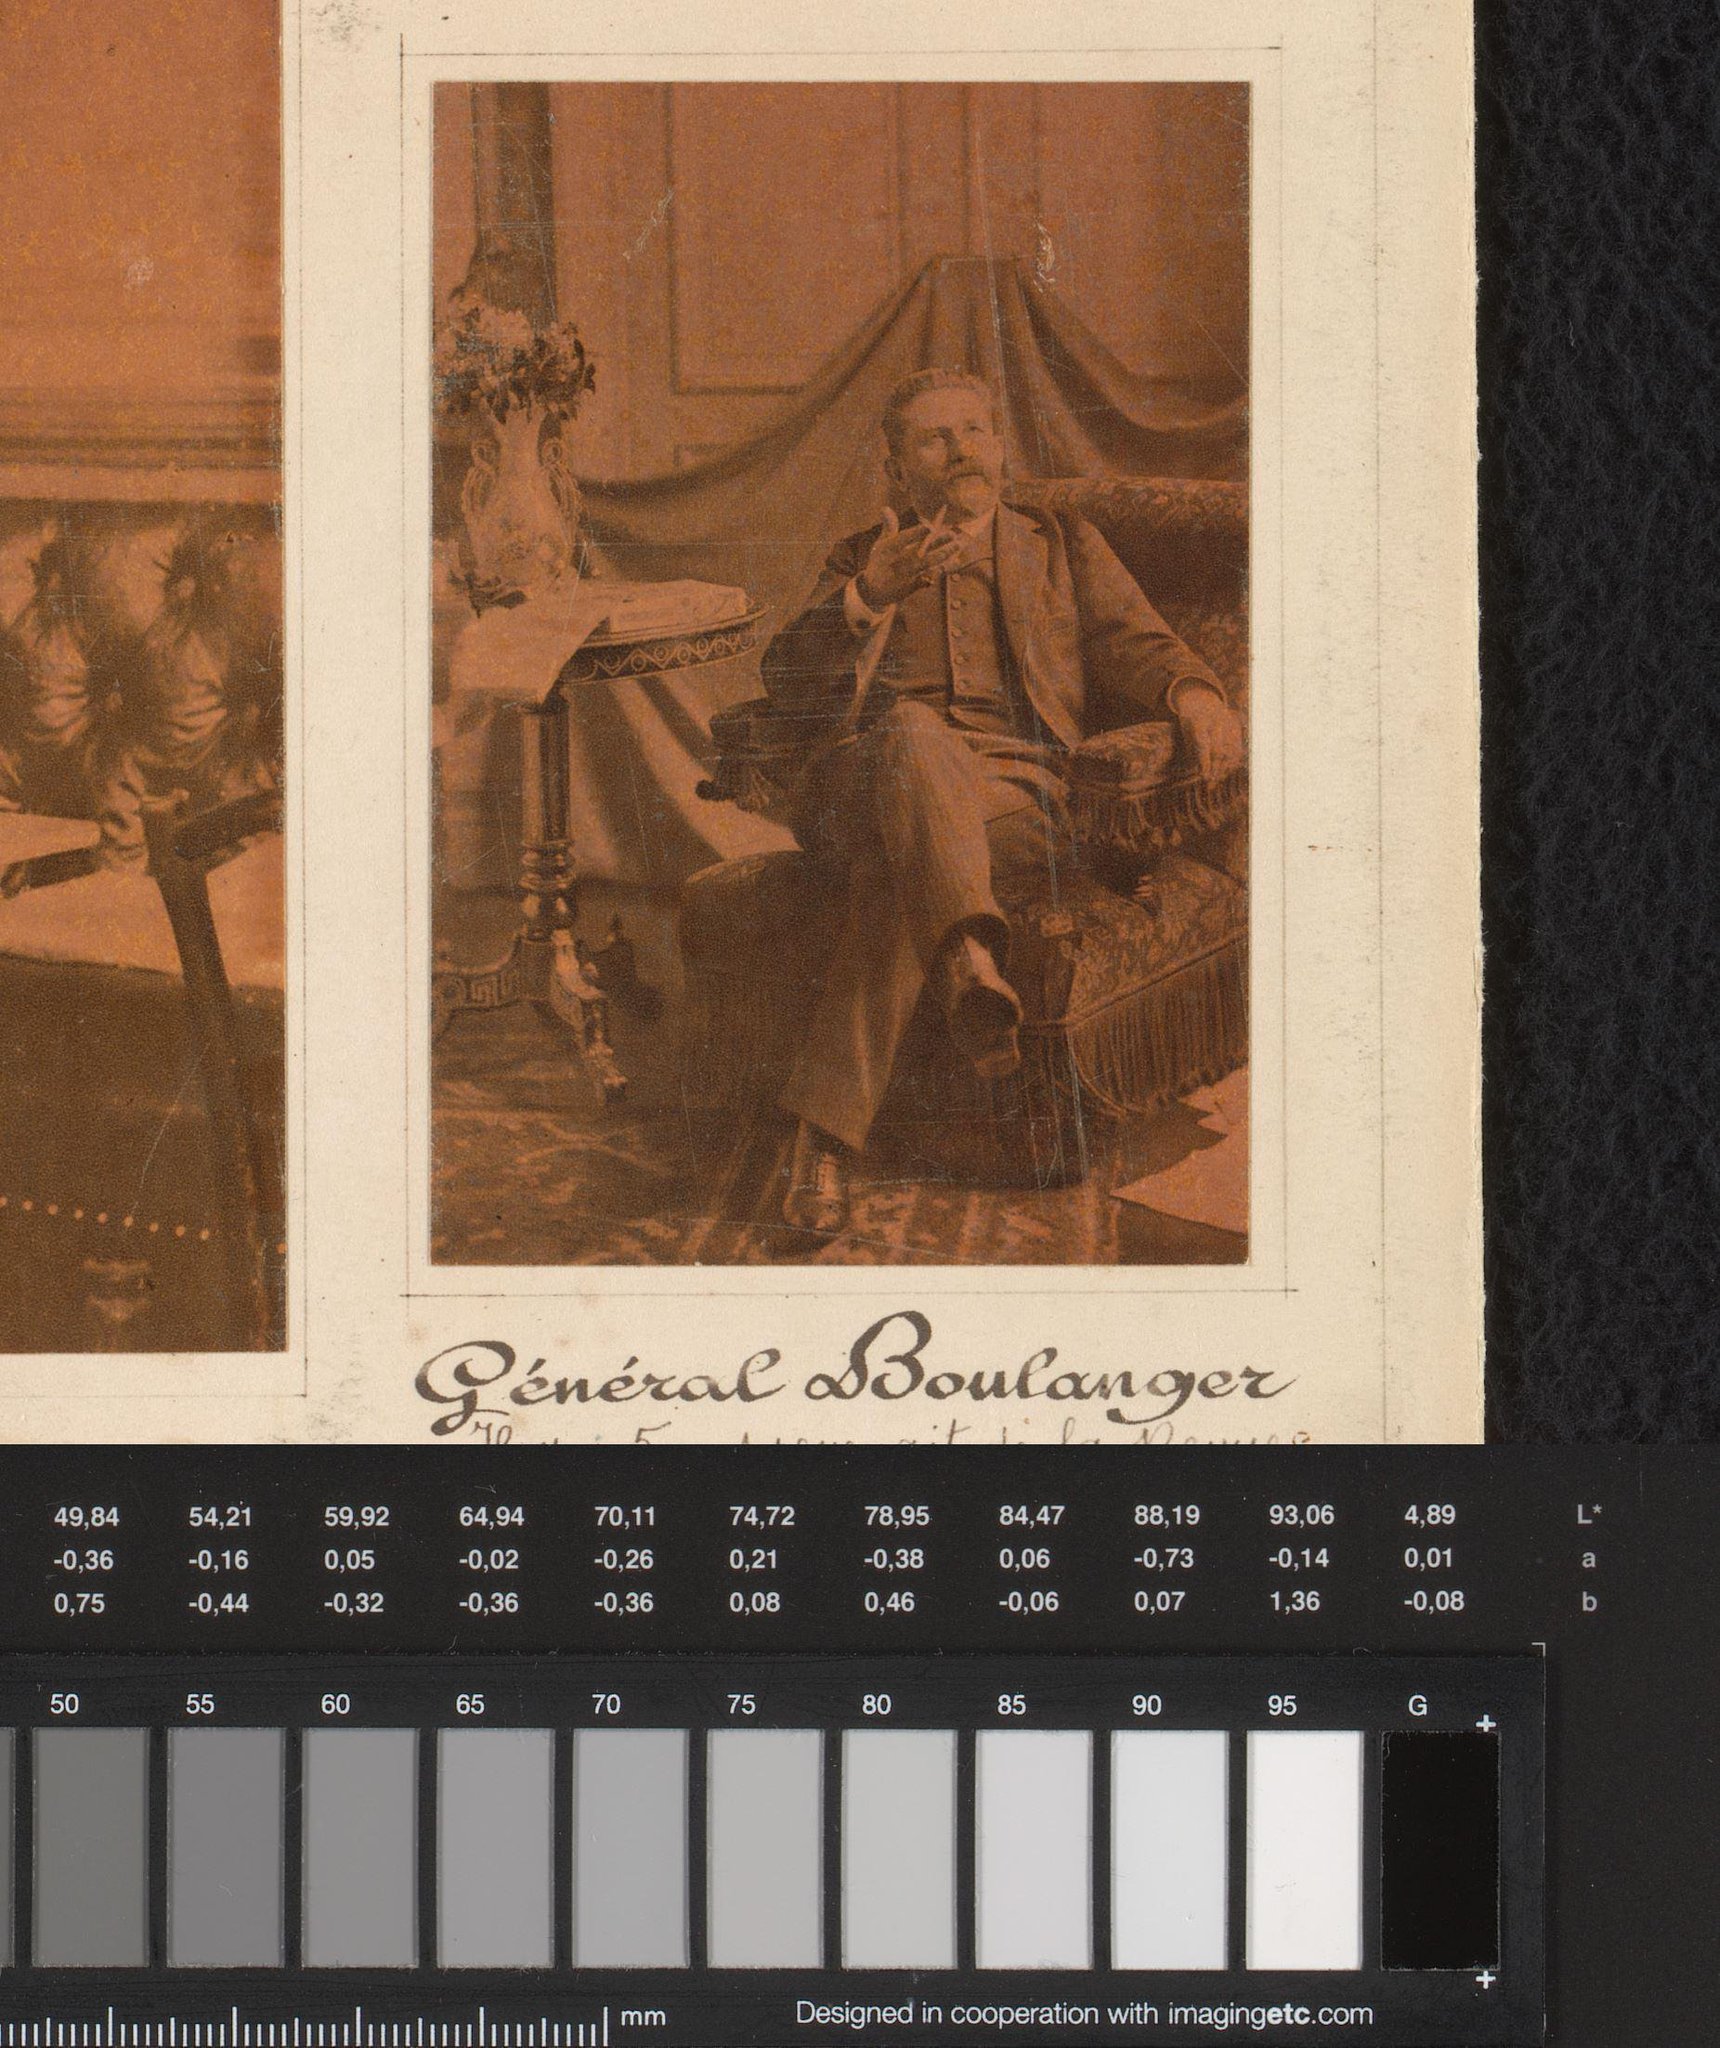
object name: album leaf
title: Portret van Georges Boulanger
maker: Anonymous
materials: paper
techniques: rotogravure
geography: france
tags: commander-in-chief, general, marshal, historical persons, france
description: Deze prent maakt deel uit van een album.